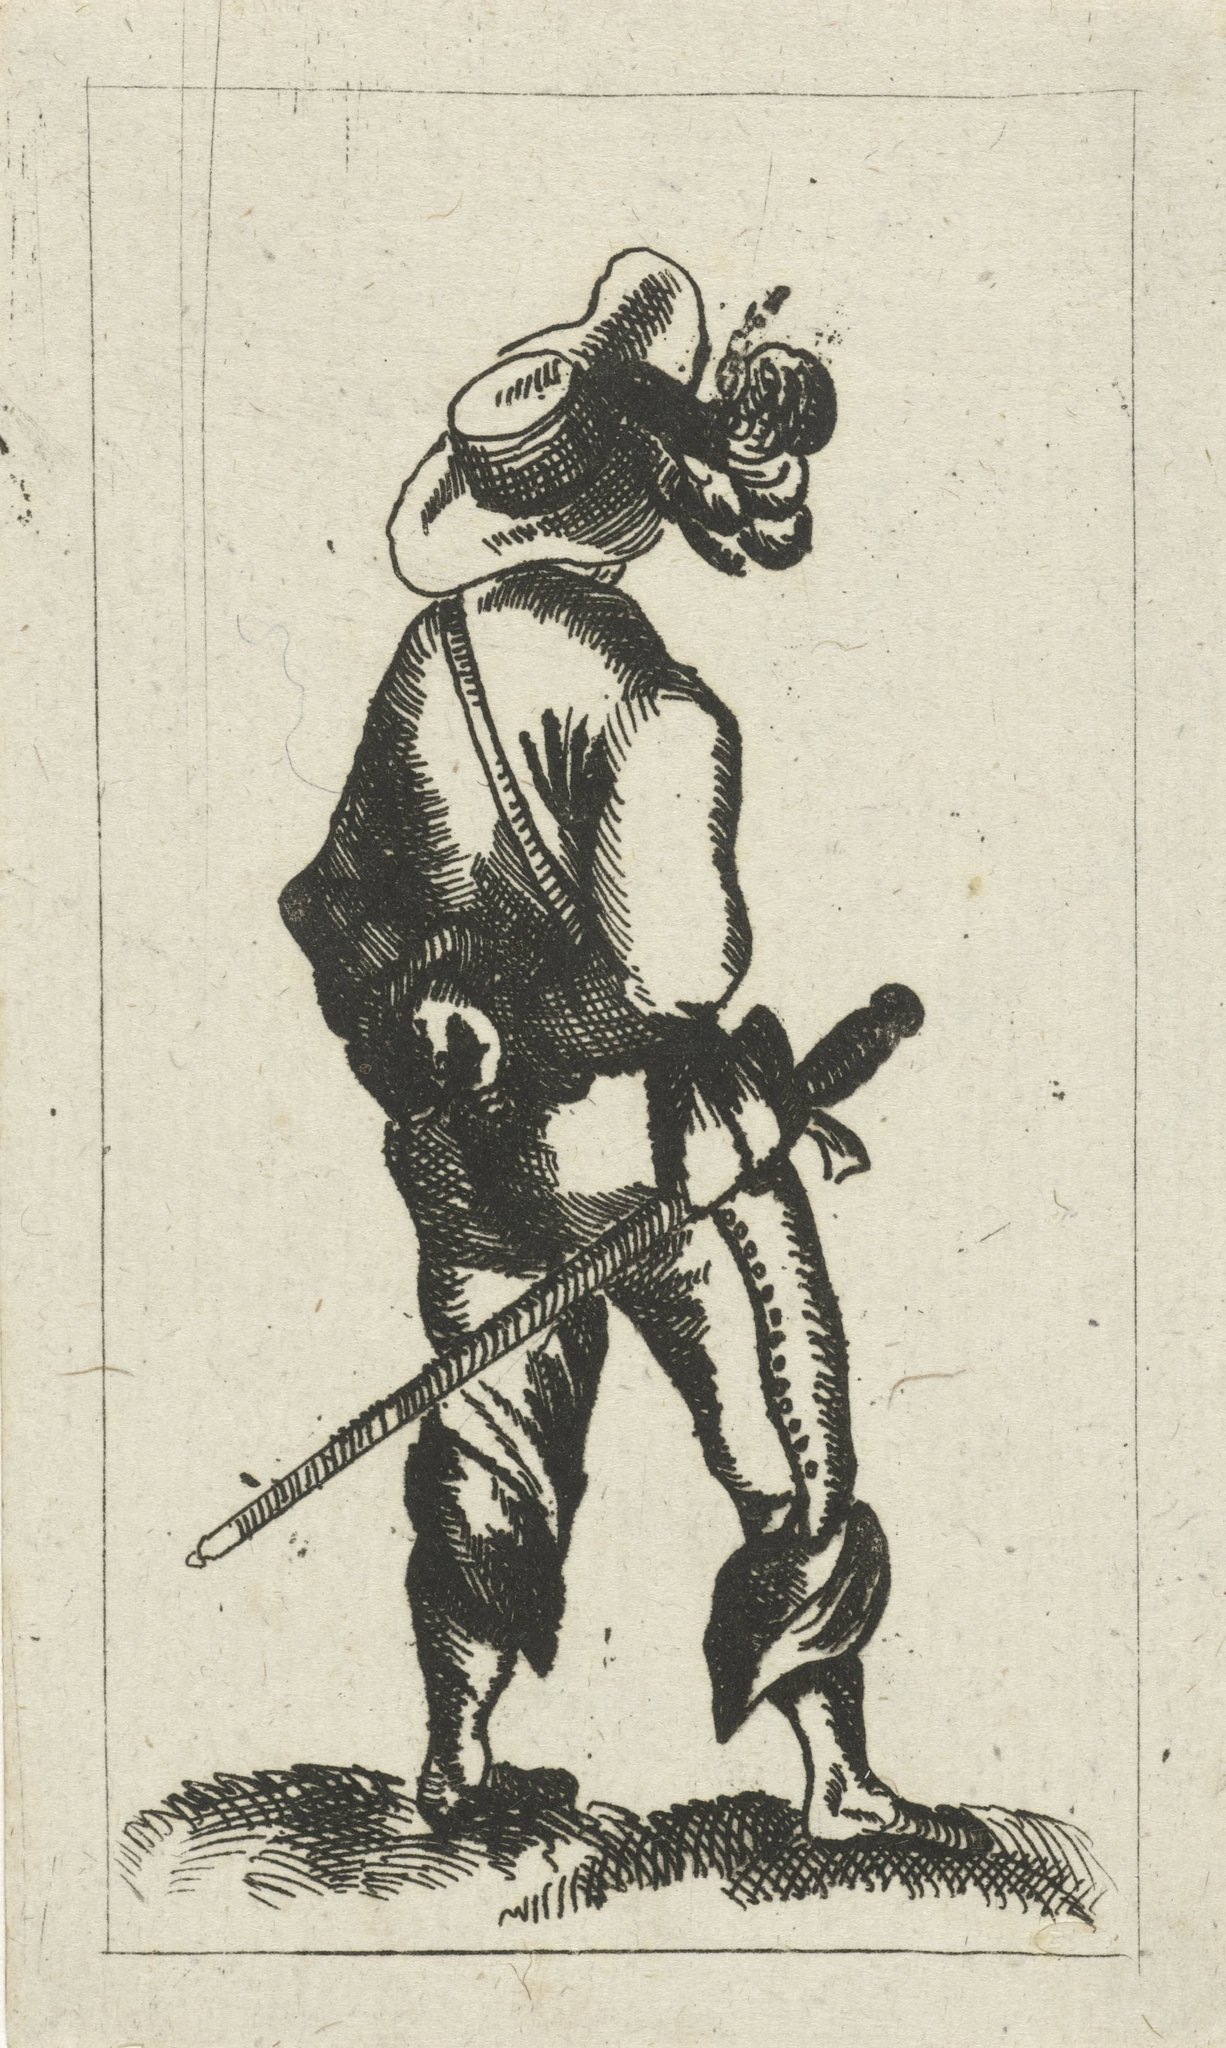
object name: print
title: Man met zwaard op de rug gezien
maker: cornelis adrianus van hoogstraten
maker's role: print maker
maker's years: 1747-1824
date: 1757-1824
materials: paper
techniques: etching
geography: leiden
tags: hacking and thrusting weapons: sword, standing figure (+ back view)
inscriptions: collector's mark: Lugt 2200, collector's mark: Lugt 2228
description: Man met zwaard aan een sjerp om zijn schouder, staande naar rechts, op de rug gezien.